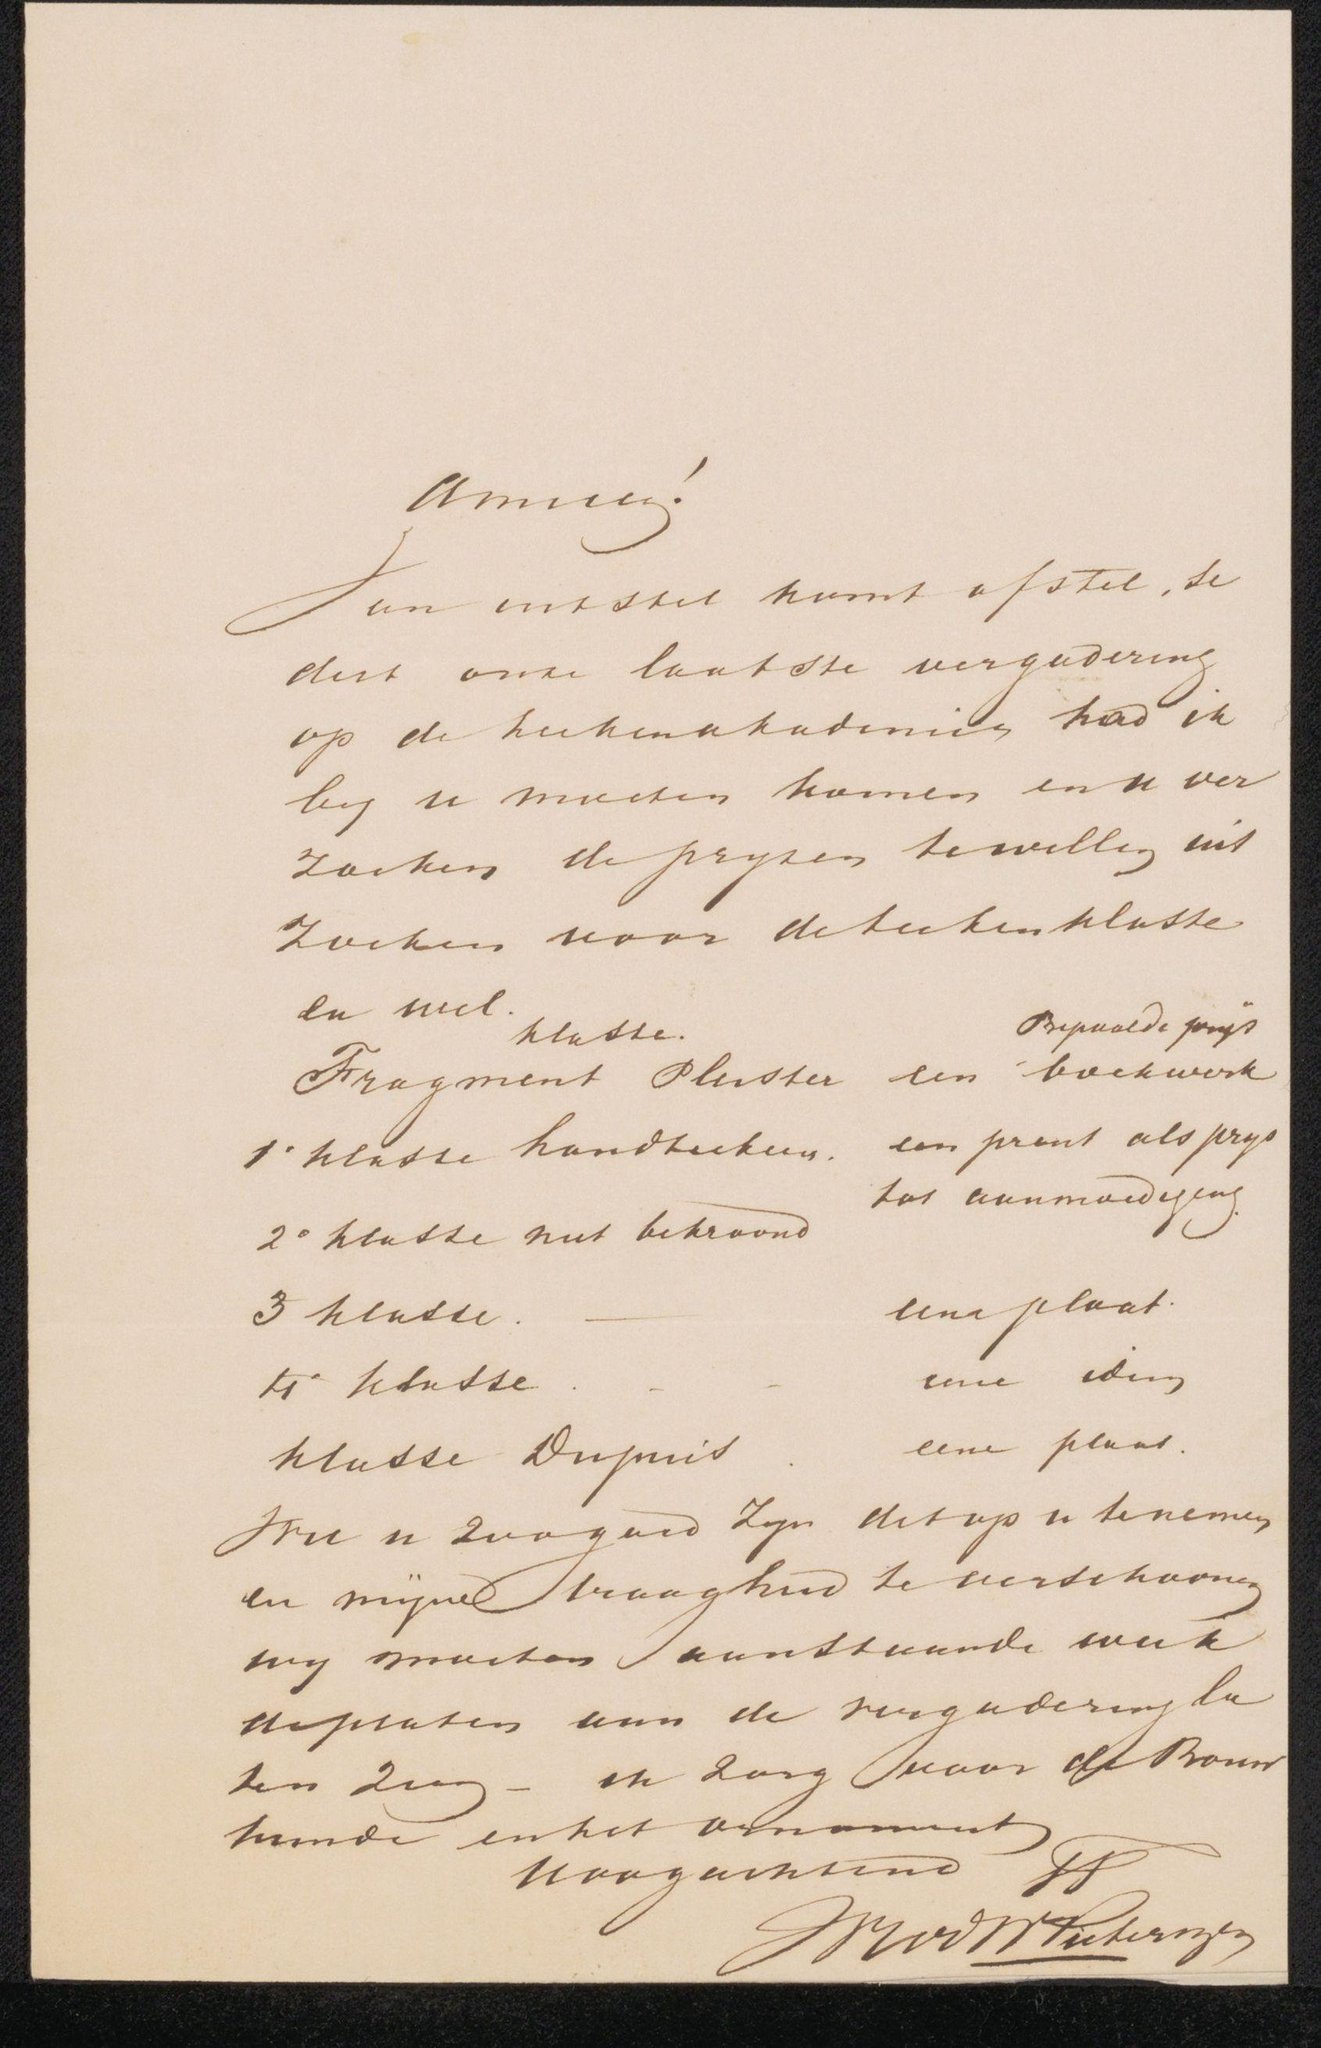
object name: letter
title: Brief aan anoniem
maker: willem cornelius van der wayen pieterszen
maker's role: architect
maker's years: 1819-1874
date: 1829-1874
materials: ink, paper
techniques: pen, writing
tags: education, tuition of the artist (in general)